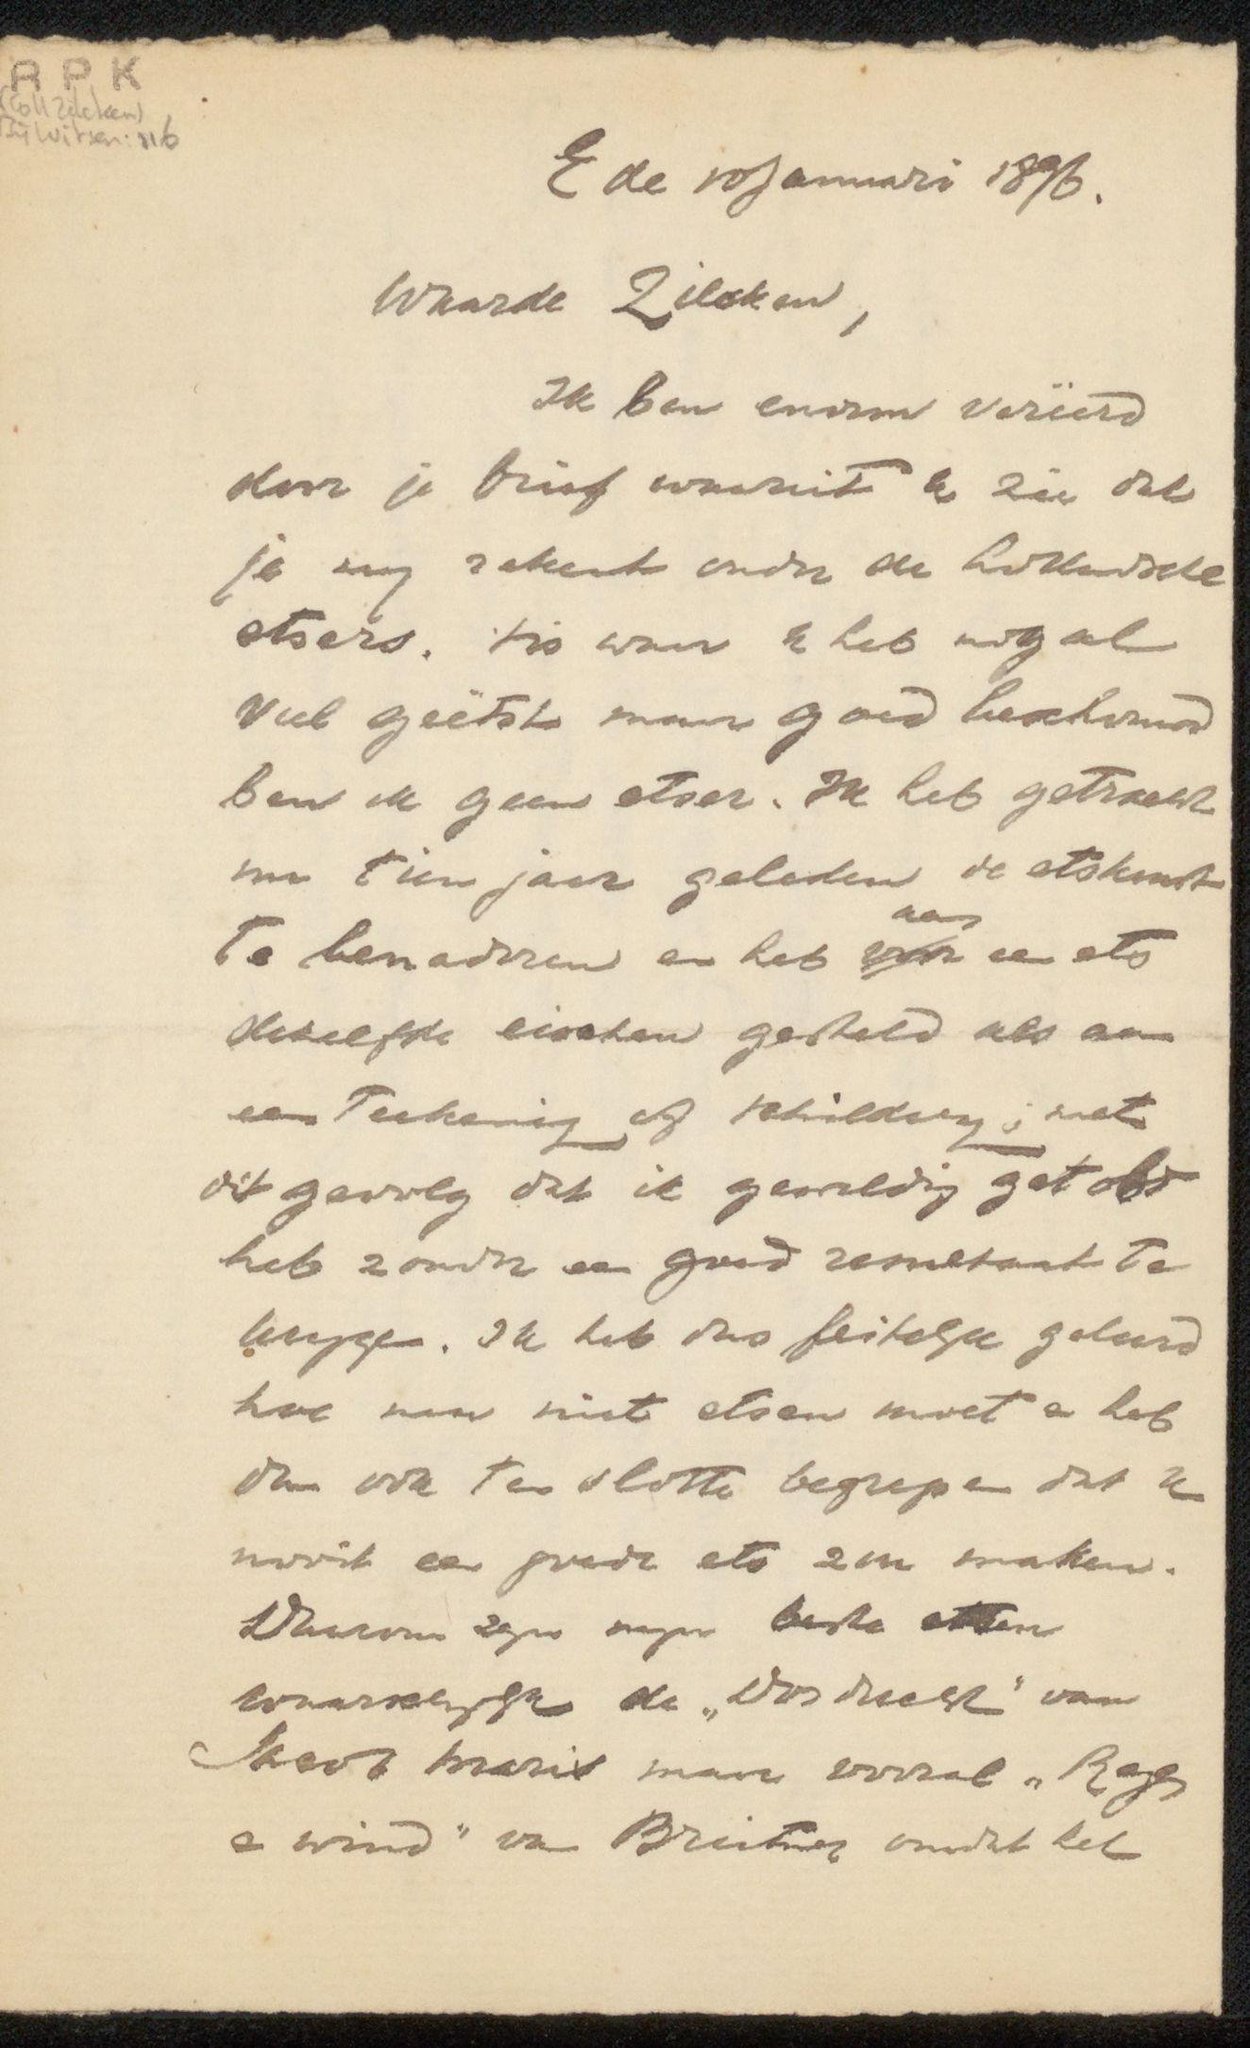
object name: letter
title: Brief aan Philip Zilcken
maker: willem witsen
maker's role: draughtsman, painter, print maker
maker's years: 1860-1923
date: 1896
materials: ink, paper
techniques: pen, writing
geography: ede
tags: jozef israëls, rotterdam, george hendrik breitner, antwerp, painter, print maker, charles verlat, arnhem, draughtsman, anton mauve, jacob maris, eduard karsen, marius bauer, philip zilcken, art trade, art shop, the graphic arts, education, tuition of the artist (in general), london, amsterdam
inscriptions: collector's mark: ‘RPK’, watermark